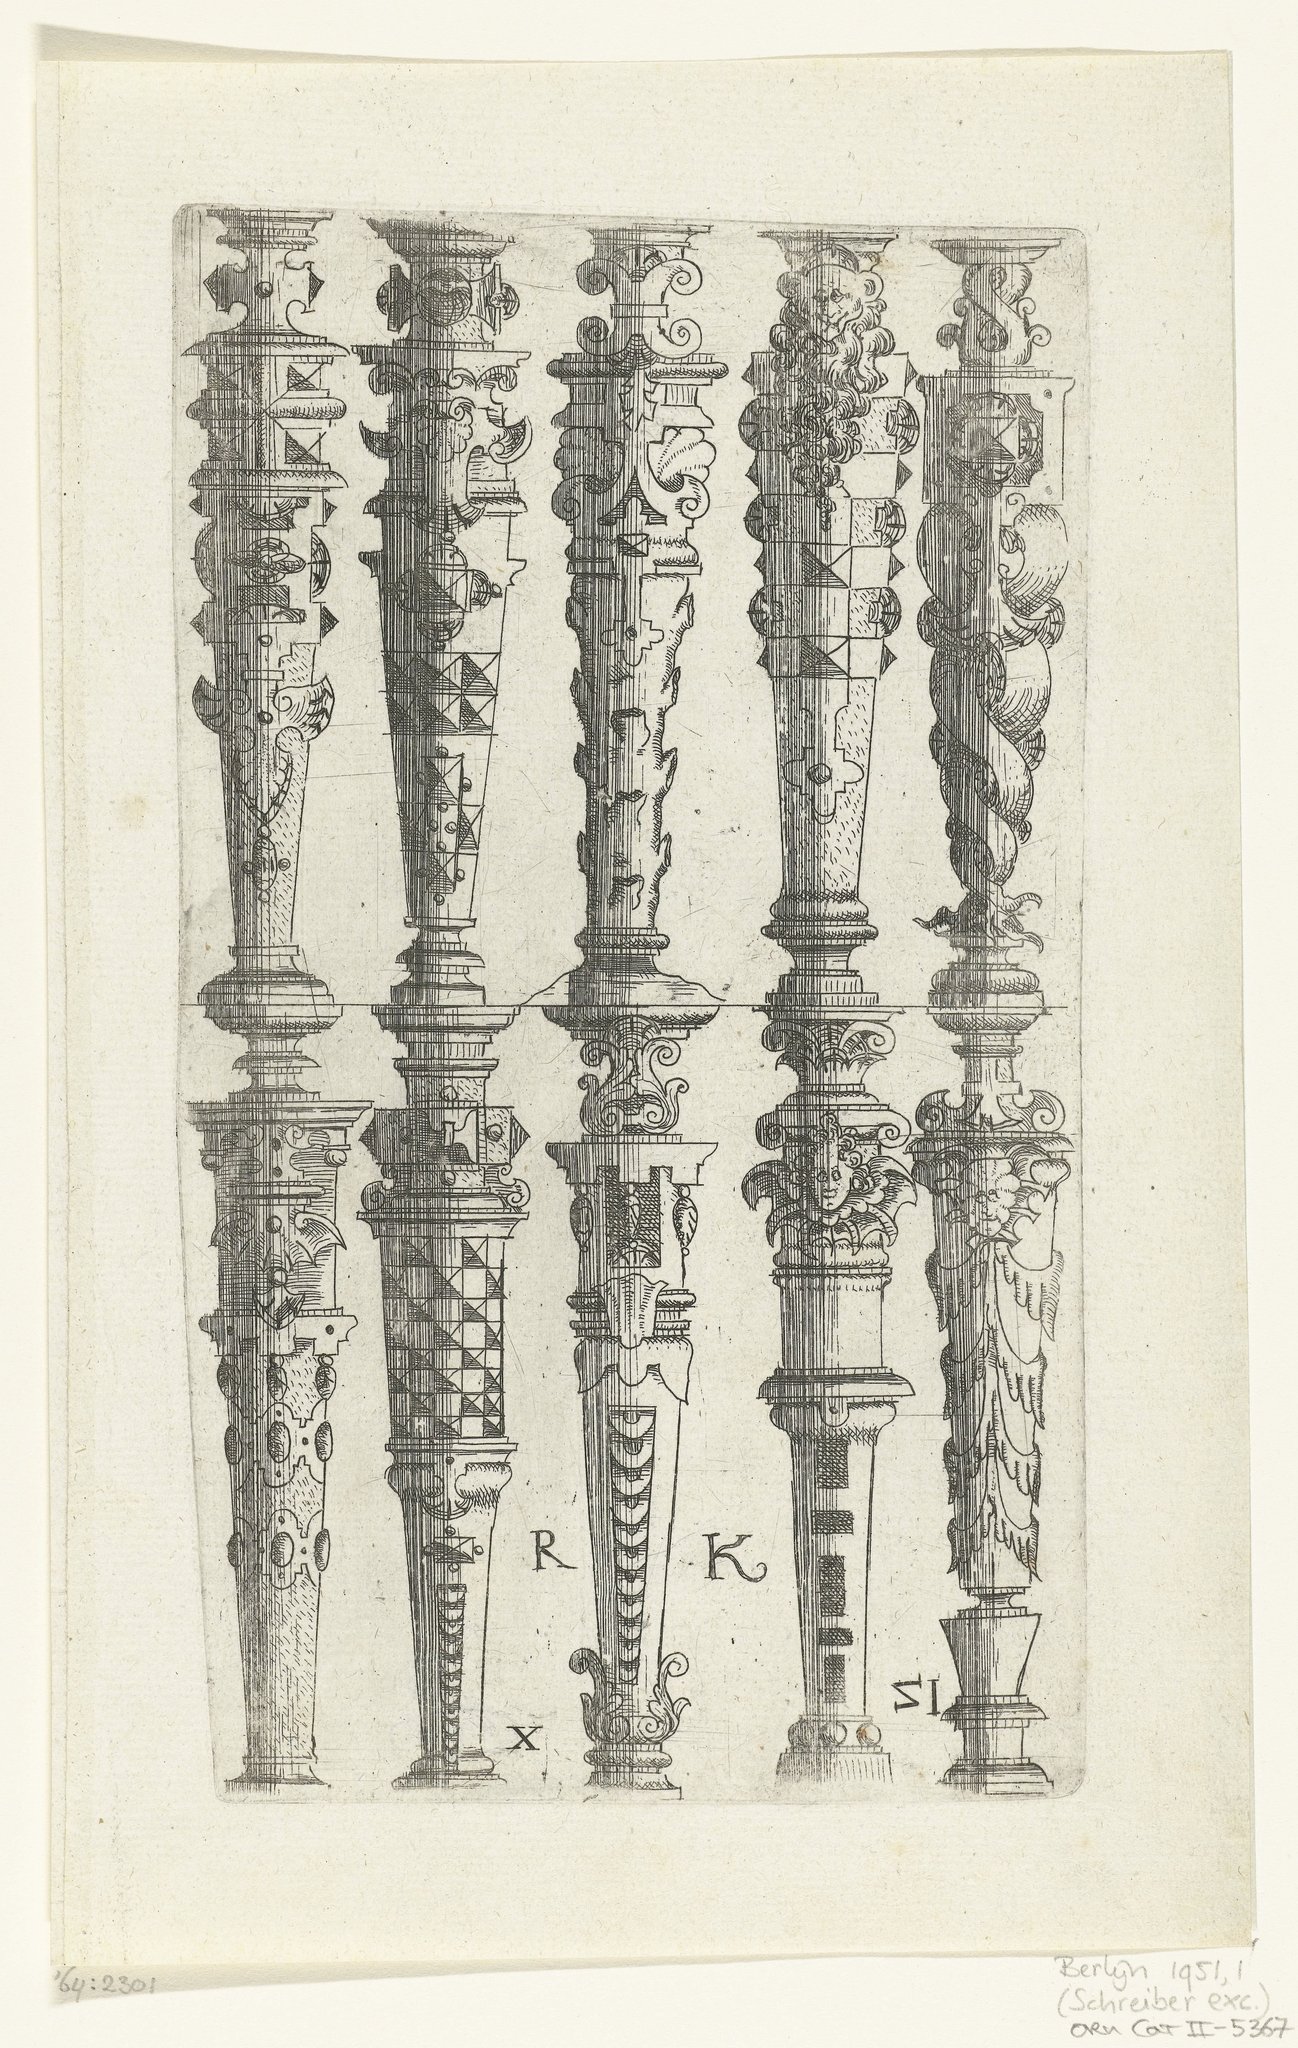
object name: print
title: Tien balusters of termen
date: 1622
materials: paper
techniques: etching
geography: germany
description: De balusters of termen met fantasiedecoraties staan in twee rijen onder elkaar. Blad X uit tweede editie van serie, bestaande uit 24 bladen.